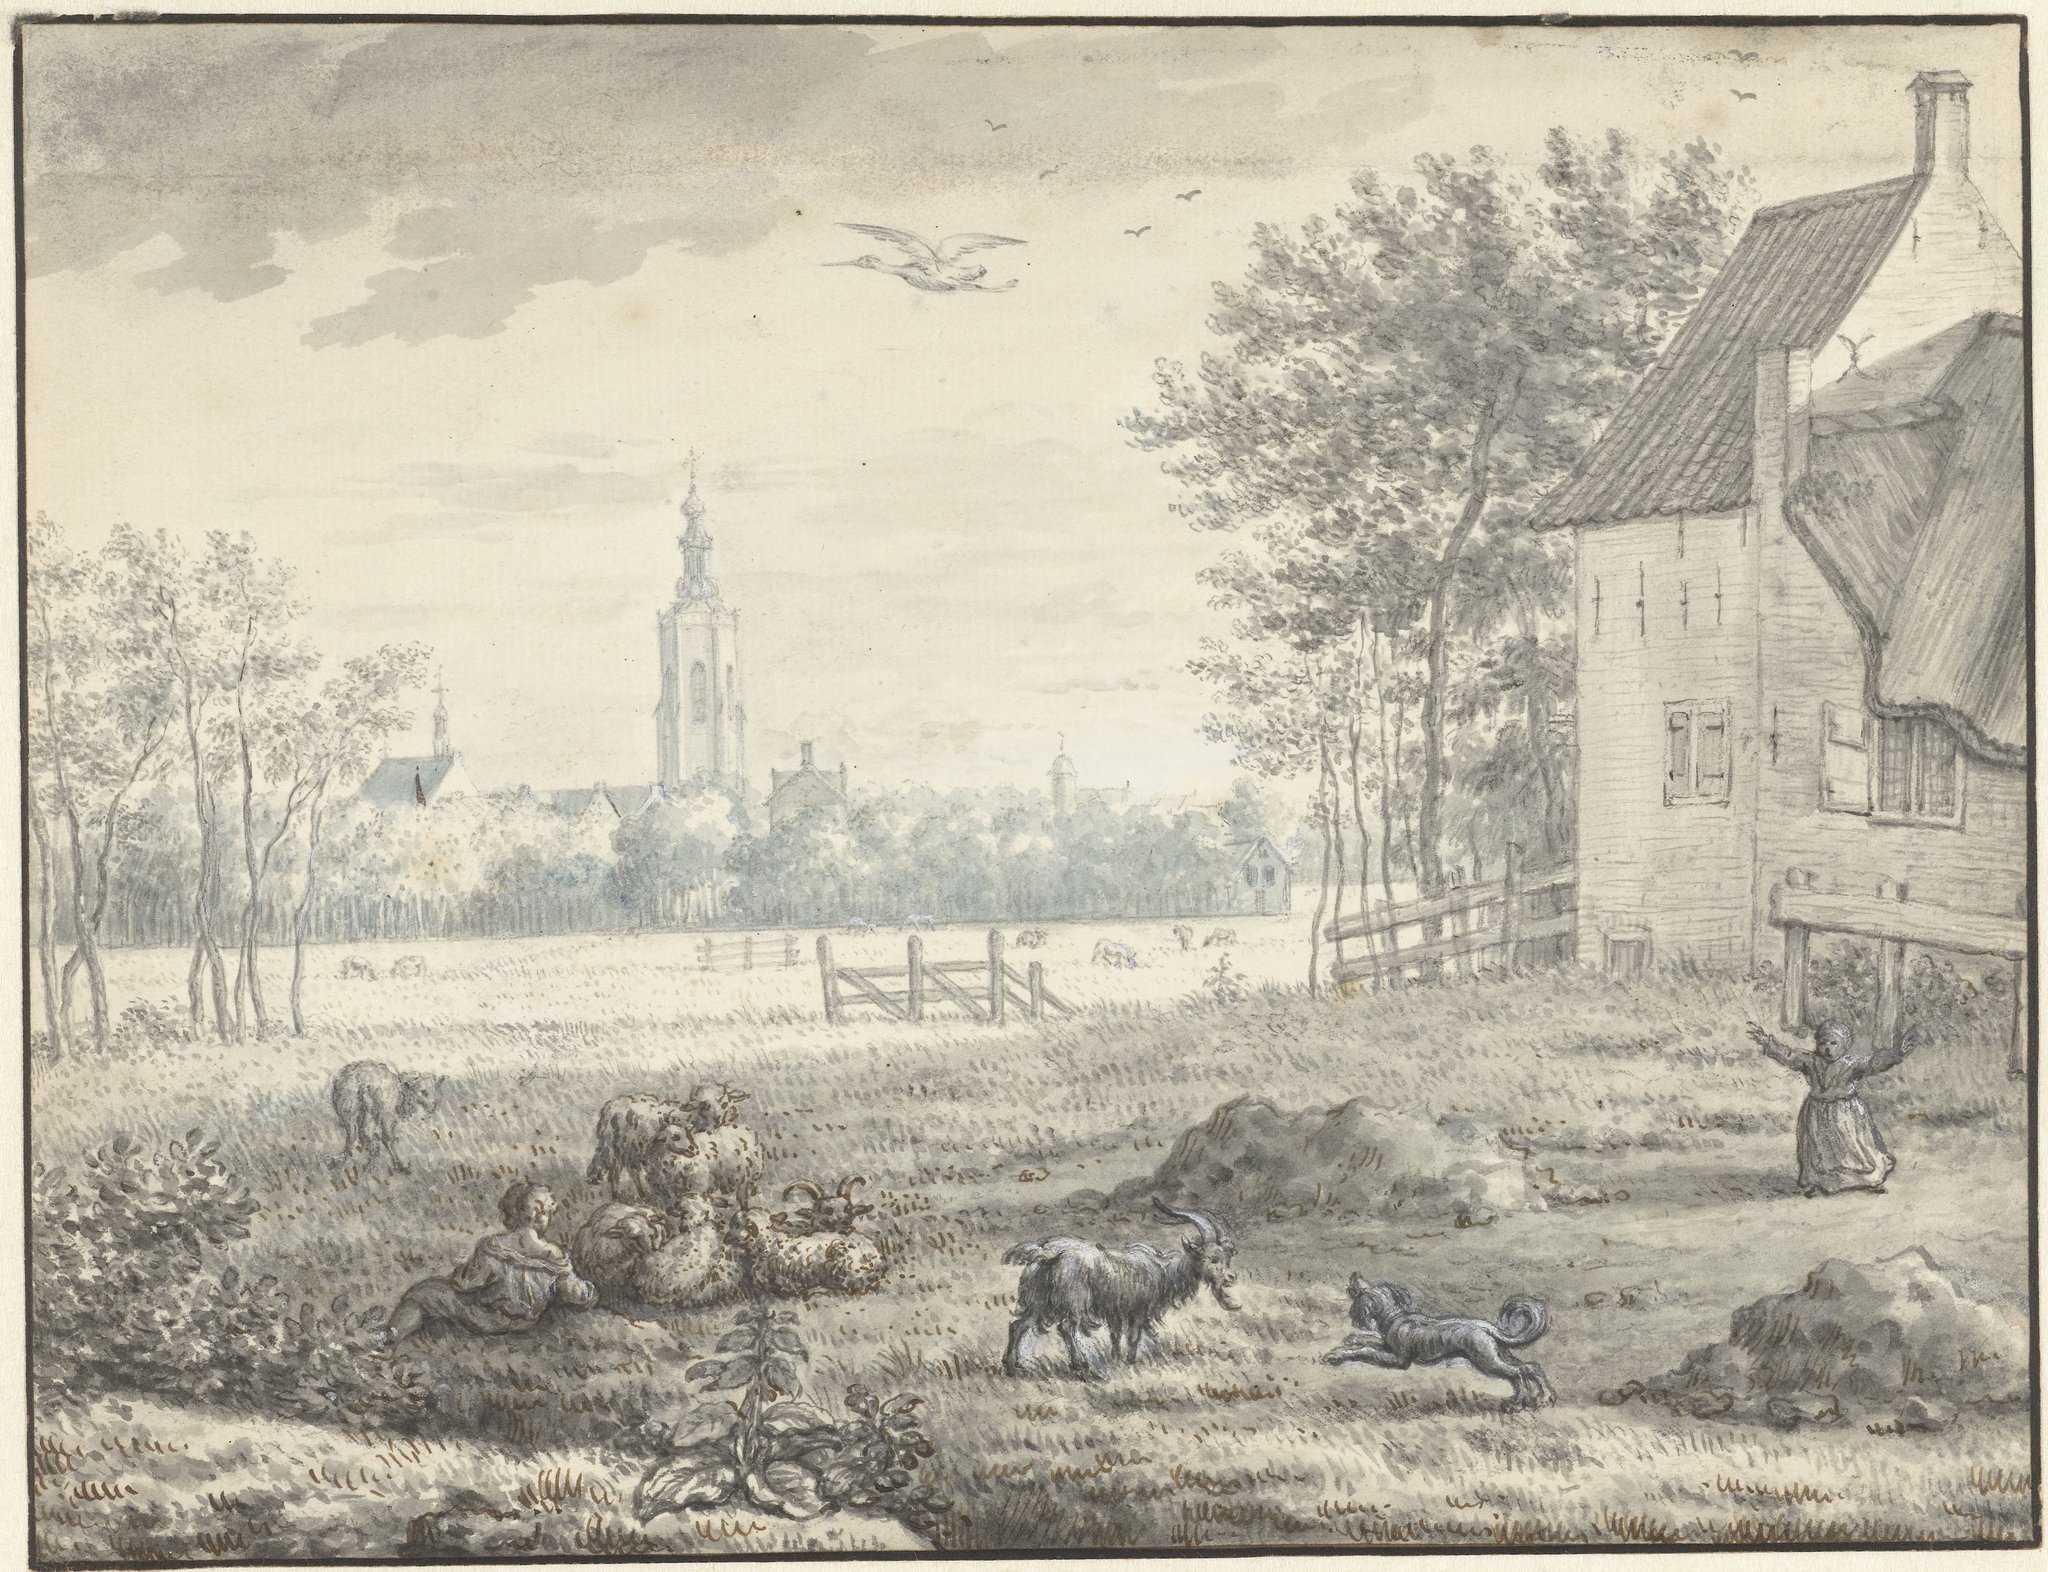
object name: drawing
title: Gezicht op Den Haag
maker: mattheus verheyden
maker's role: draughtsman, painter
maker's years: 1700-1777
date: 1740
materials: chalk, ink, paper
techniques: brush, pen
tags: village, the hague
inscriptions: inscription: ‘Gezicht van den Haag. soo als het zig vertoont, ter linker zeijde de weg van Scheveninge in de Laan over Schudde Beurs. Staende bij de Boere woninge agter zig hebbende de Tuijnen van het huijs van de Princesse van Hessen Philipsdall &c na 't leven getekent op den 10 october 1740 door Mattheus Verheijden’